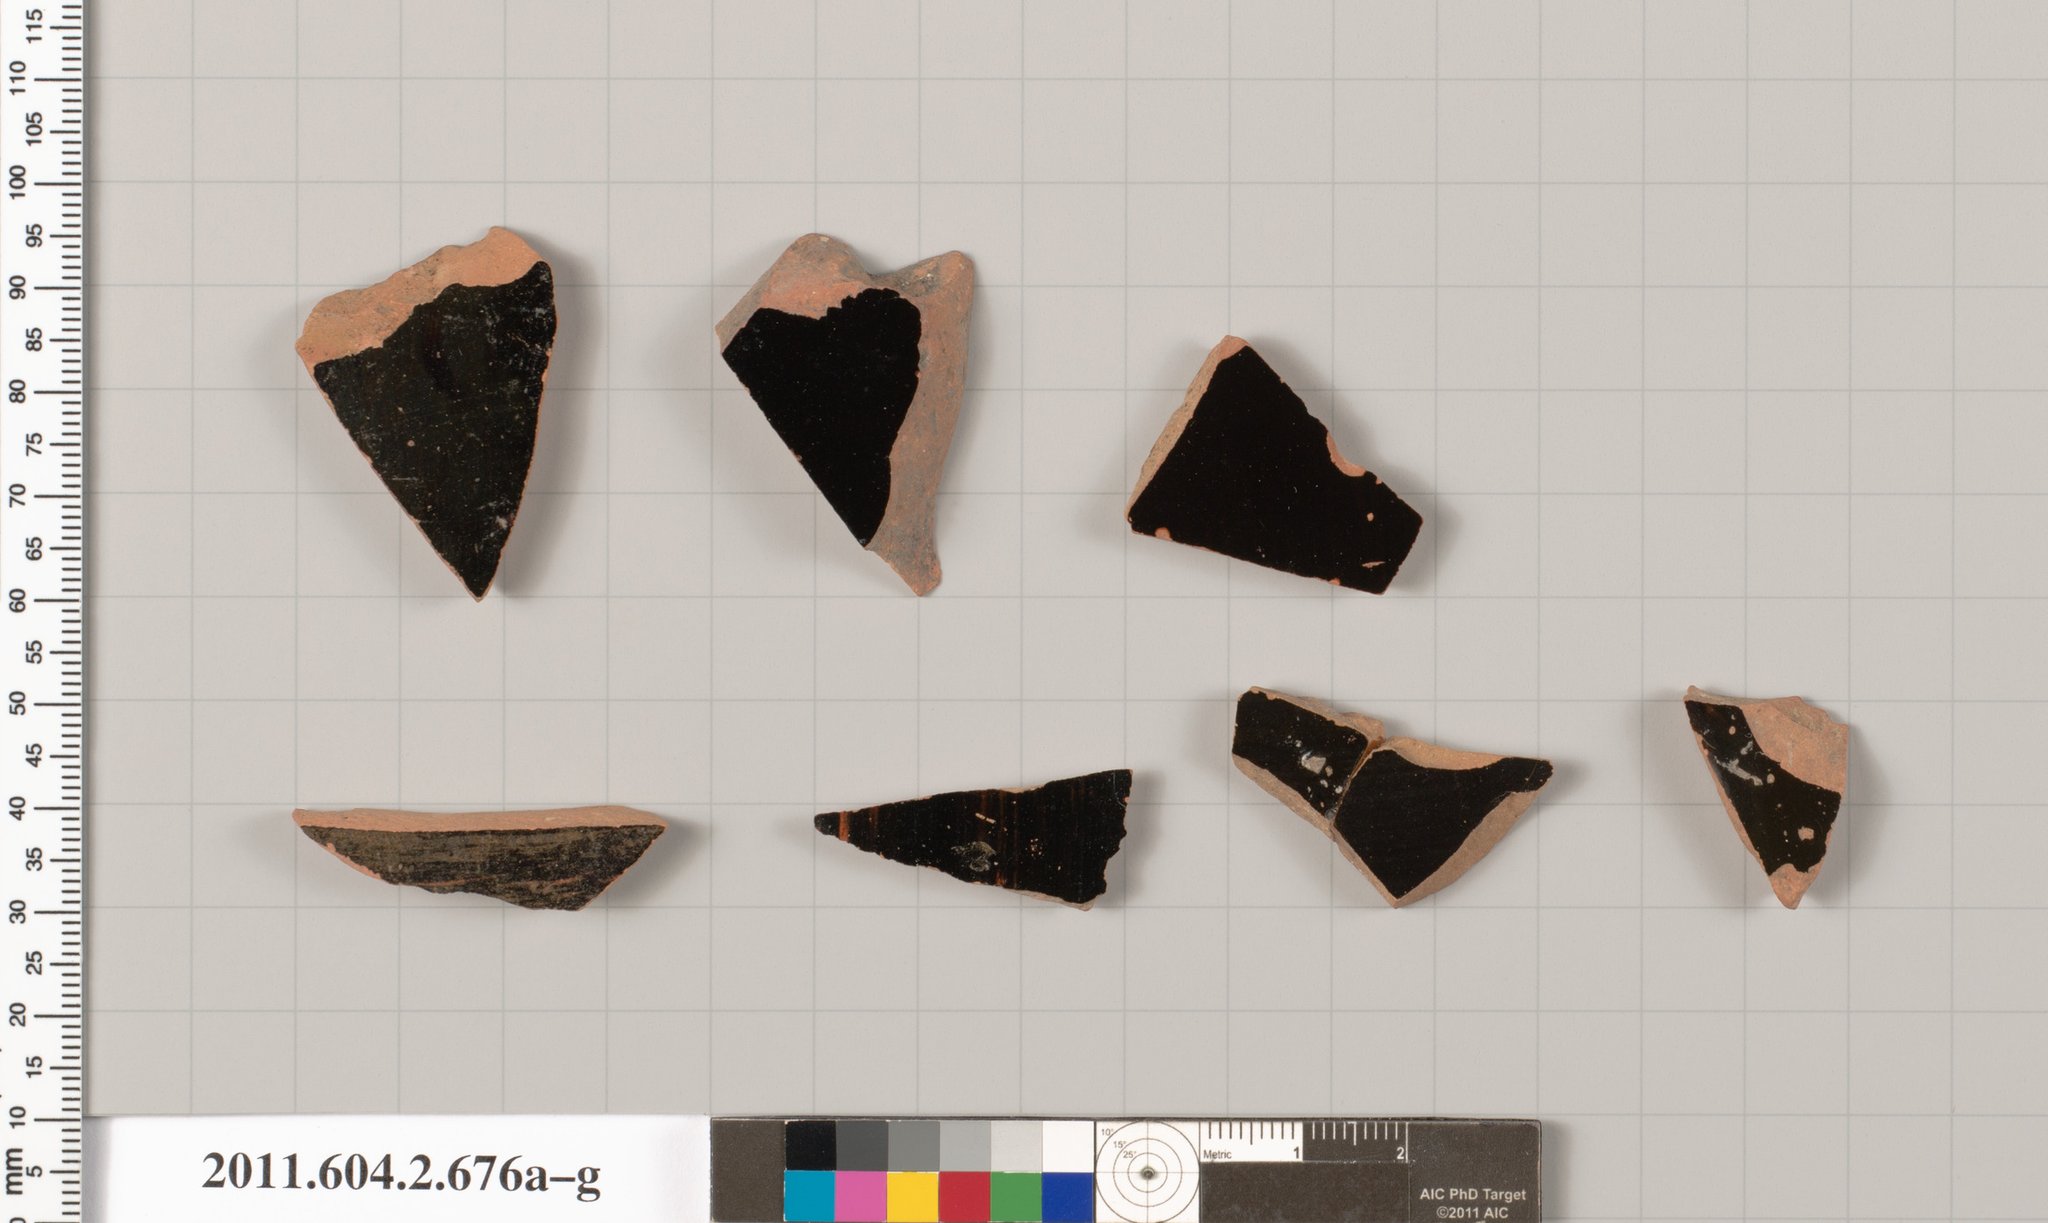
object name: column krater fragment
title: Terracotta fragments of column-kraters (bowls for mixing wine and water)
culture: greek, attic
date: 475-440 BCE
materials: terracotta